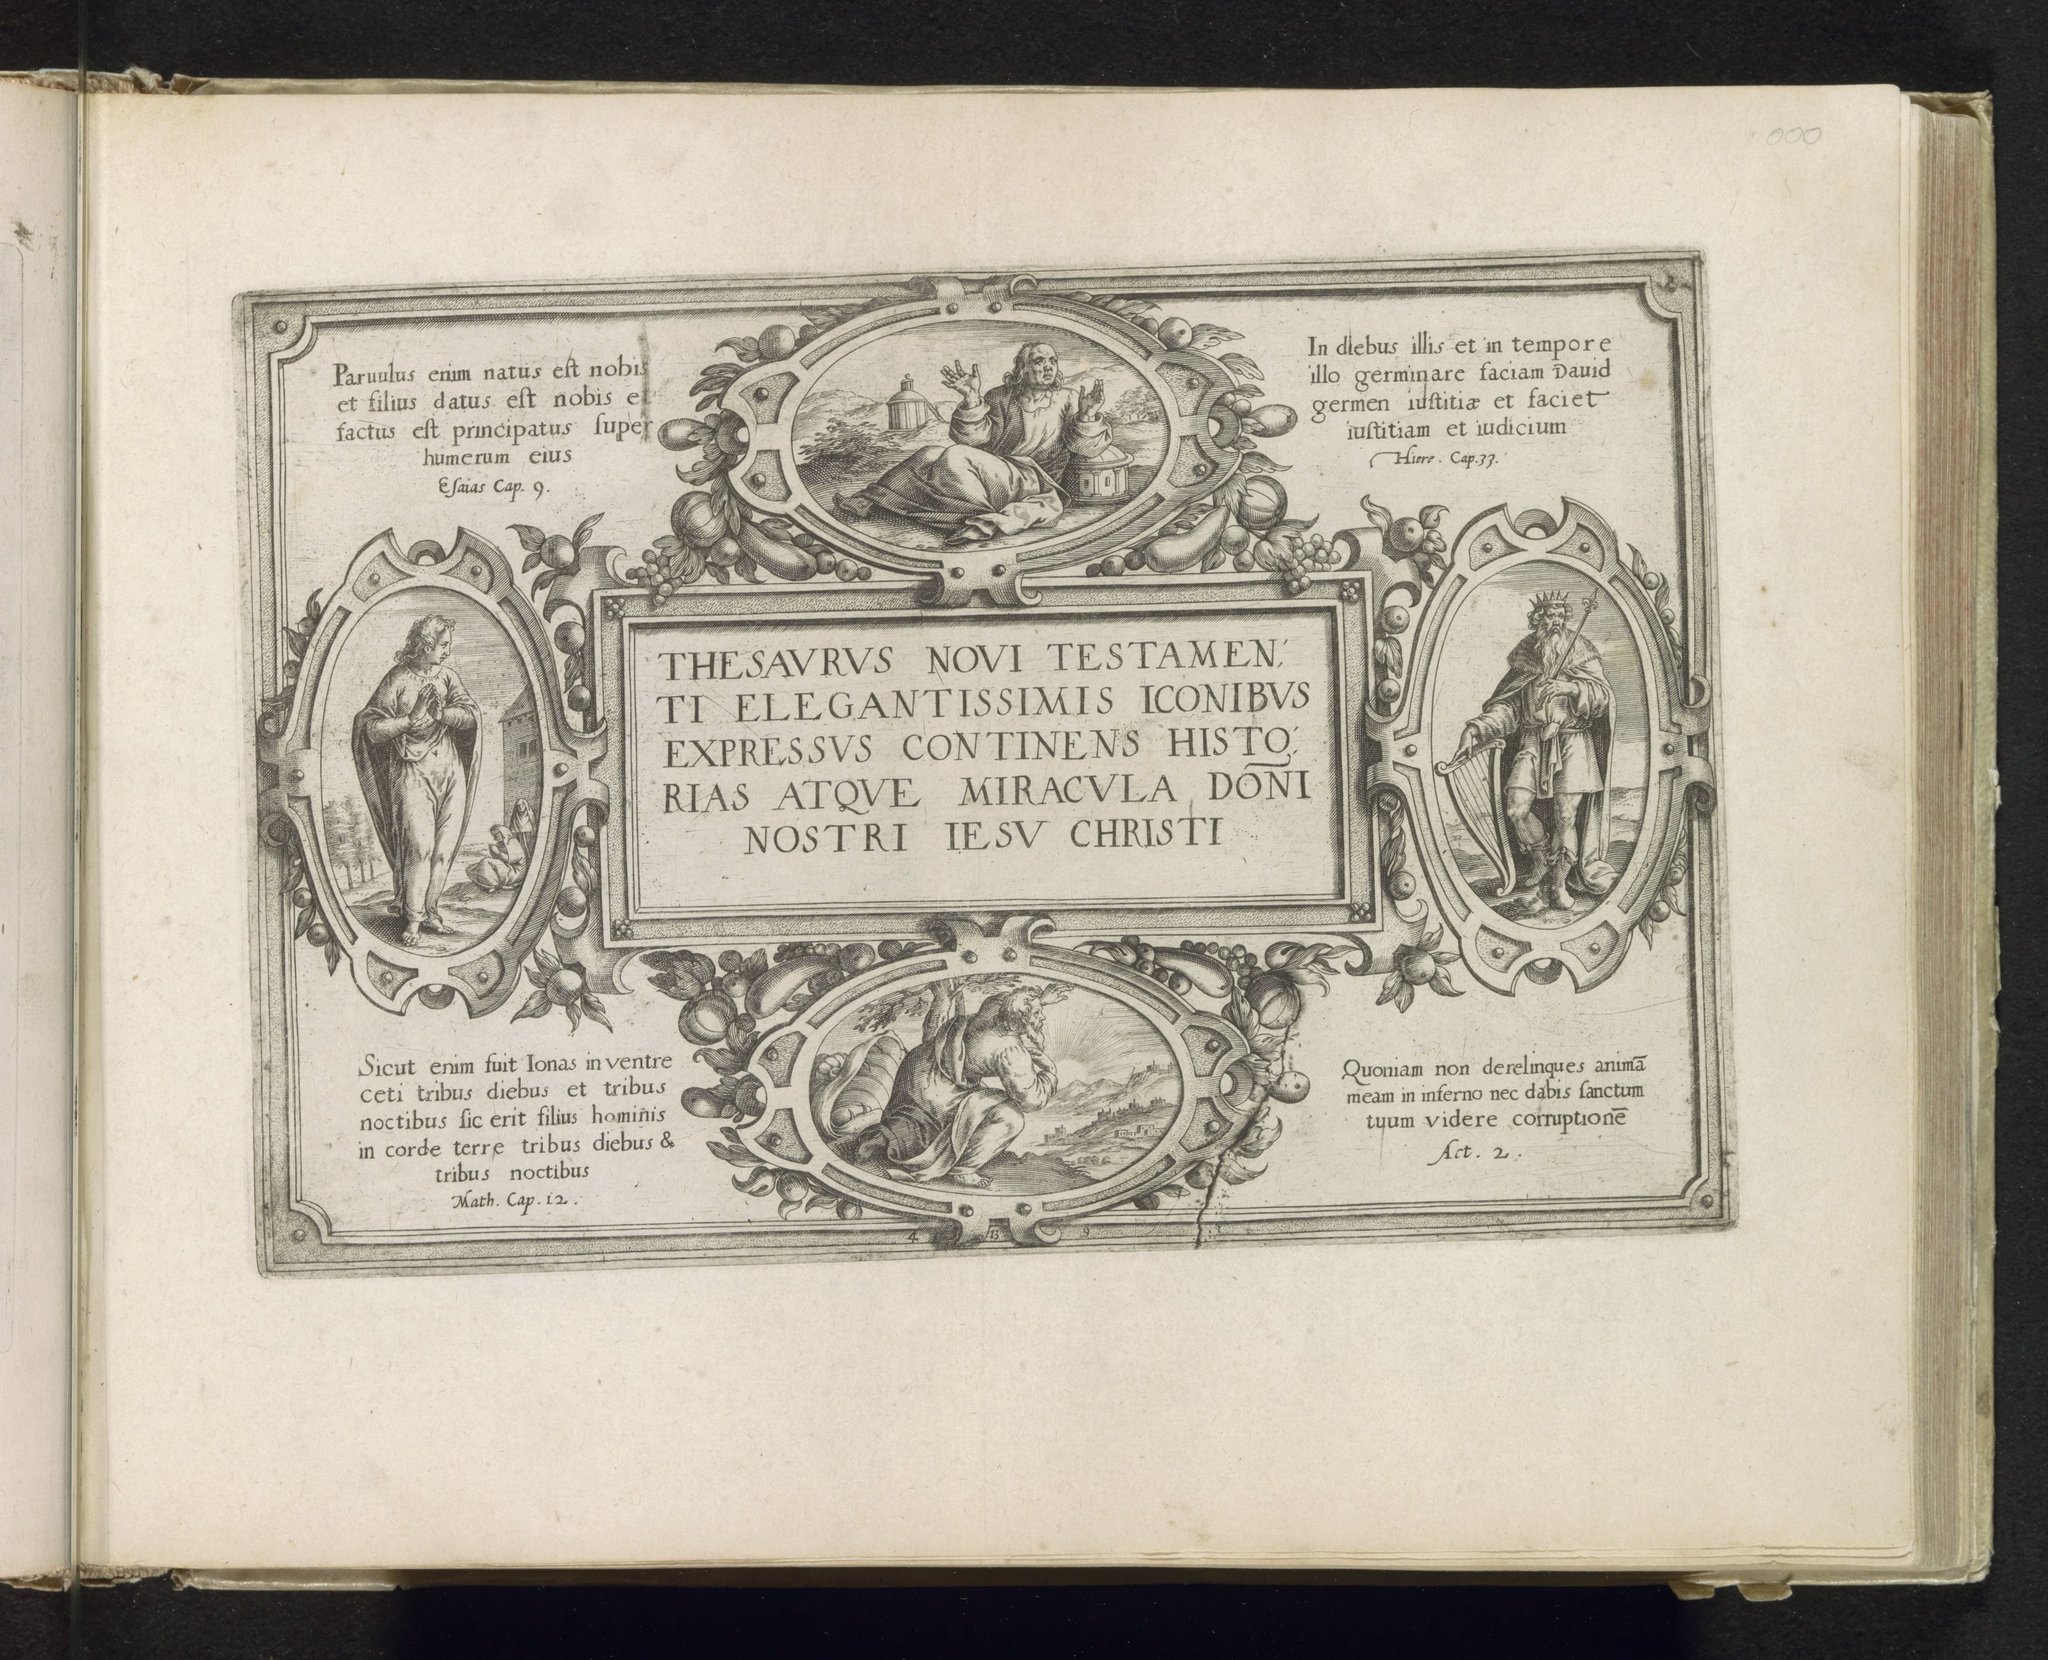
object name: titelprent, frontispice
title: Thesaurus novi Testamenti elegantissimis iconibus expressus continens historias atque miracula doni nostri Iesu Christi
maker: gerard de jode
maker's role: draughtsman, print maker, publisher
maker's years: 1508-1591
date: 1585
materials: paper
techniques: engraving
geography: antwerp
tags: fruits and vegetables ~ ornament, david (not in biblical context); possible attributes: crown, harp, male persons from the old testament (not in biblical context), jeremiah (not in biblical context); possible attributes: book or scroll, 'the seething pot', isaiah (not in biblical context); possible attributes: branch with leaves, saw, scroll or book, after a three-day sojourn in the belly of the monster jonah is cast on dry land; jonah may be shown nude and bald-headed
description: Een serietitel in het Latijn in een cartouche, omgeven door vier ornamentele cartouches met profeten uit het Oude Testament. Links de profeet Jesaja met daarboven een verwijzing in het Latijn naar Jes. 9. Midden boven de profeet Jeremia met daarnaast een verwijzing in het Latijn naar Jer. 33. Midden onder de profeet Jona, die door de vis aan land wordt gespuugd, met links een verwijzing in het Latijn naar Mat. 12. Rechts koning David met zijn harp met daaronder een verwijzing in het Latijn naar Hand. 2. Rond de cartouches vruchtenguirlandes. Titelprent voor een serie van voorstellingen bij het Nieuwe Testament. Deze prent maakt deel uit van een album.